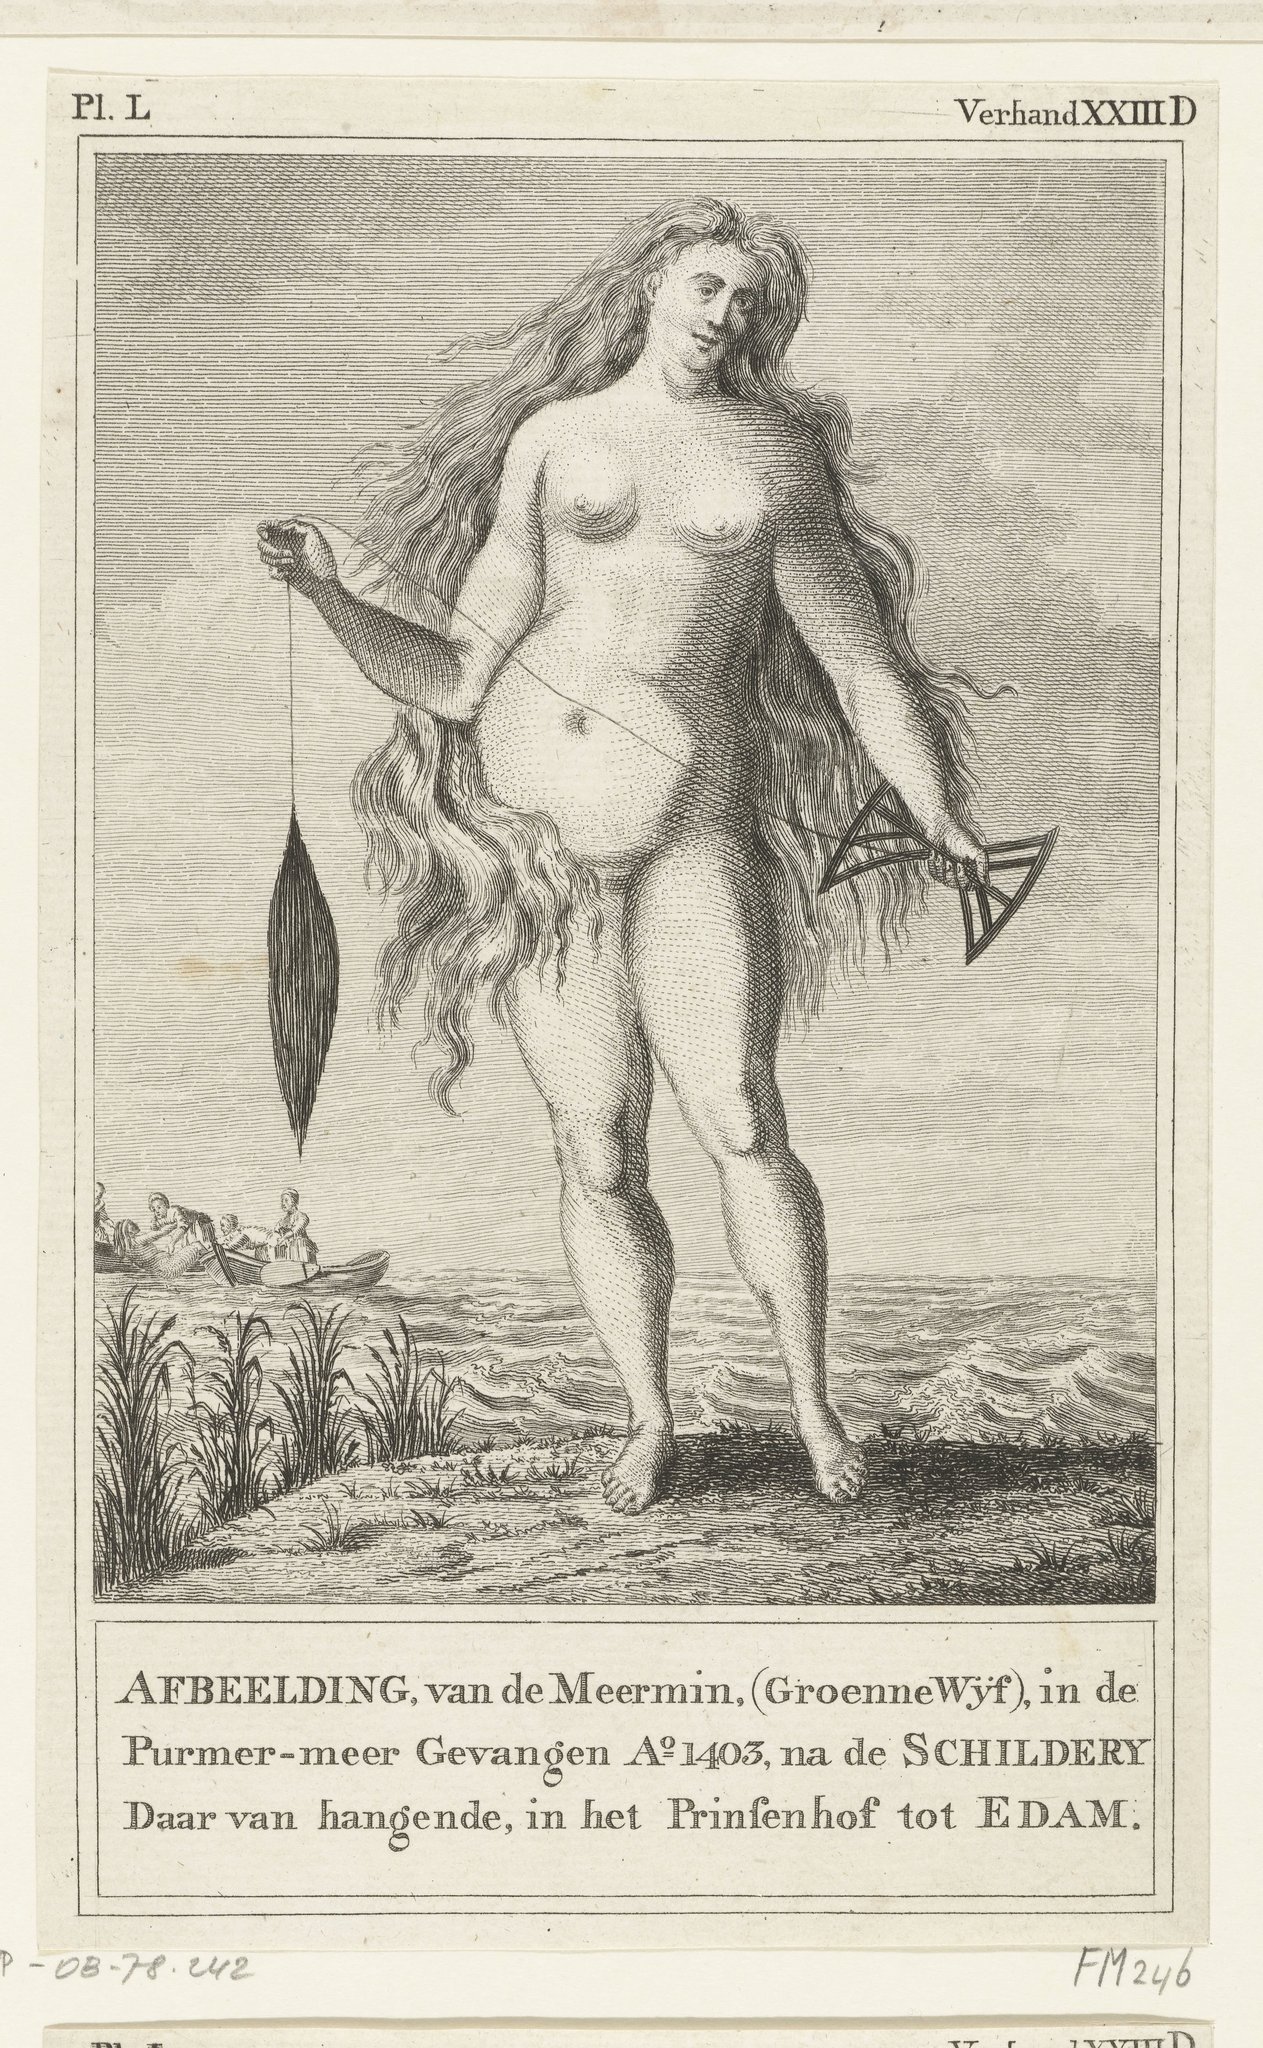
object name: print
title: Afbeelding van de Meermin, (Groenne Wijf), in de Purmer-meer gevangen A.o 1403, na de schildery daar van hangende, in het Prinsenhof tot Edam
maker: Anonymous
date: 1784-1786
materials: paper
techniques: engraving, etching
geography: northern netherlands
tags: merman, burgundian netherlands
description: Prent volgens Frederik Muller ook gebruikt in: Vosmaer, Arnout. 'Beschryving van de zoogenaamde meermin der stad Haarlem' in: Verhandelingen, uitgegeeven door de Hollandsche Maatschappye der Weetenschappen te Haarlem. Haarlem: Jan van Walré, 1786, dl. 23, plaat L. Naar een schilderij in het Prinsenhof te Edam.